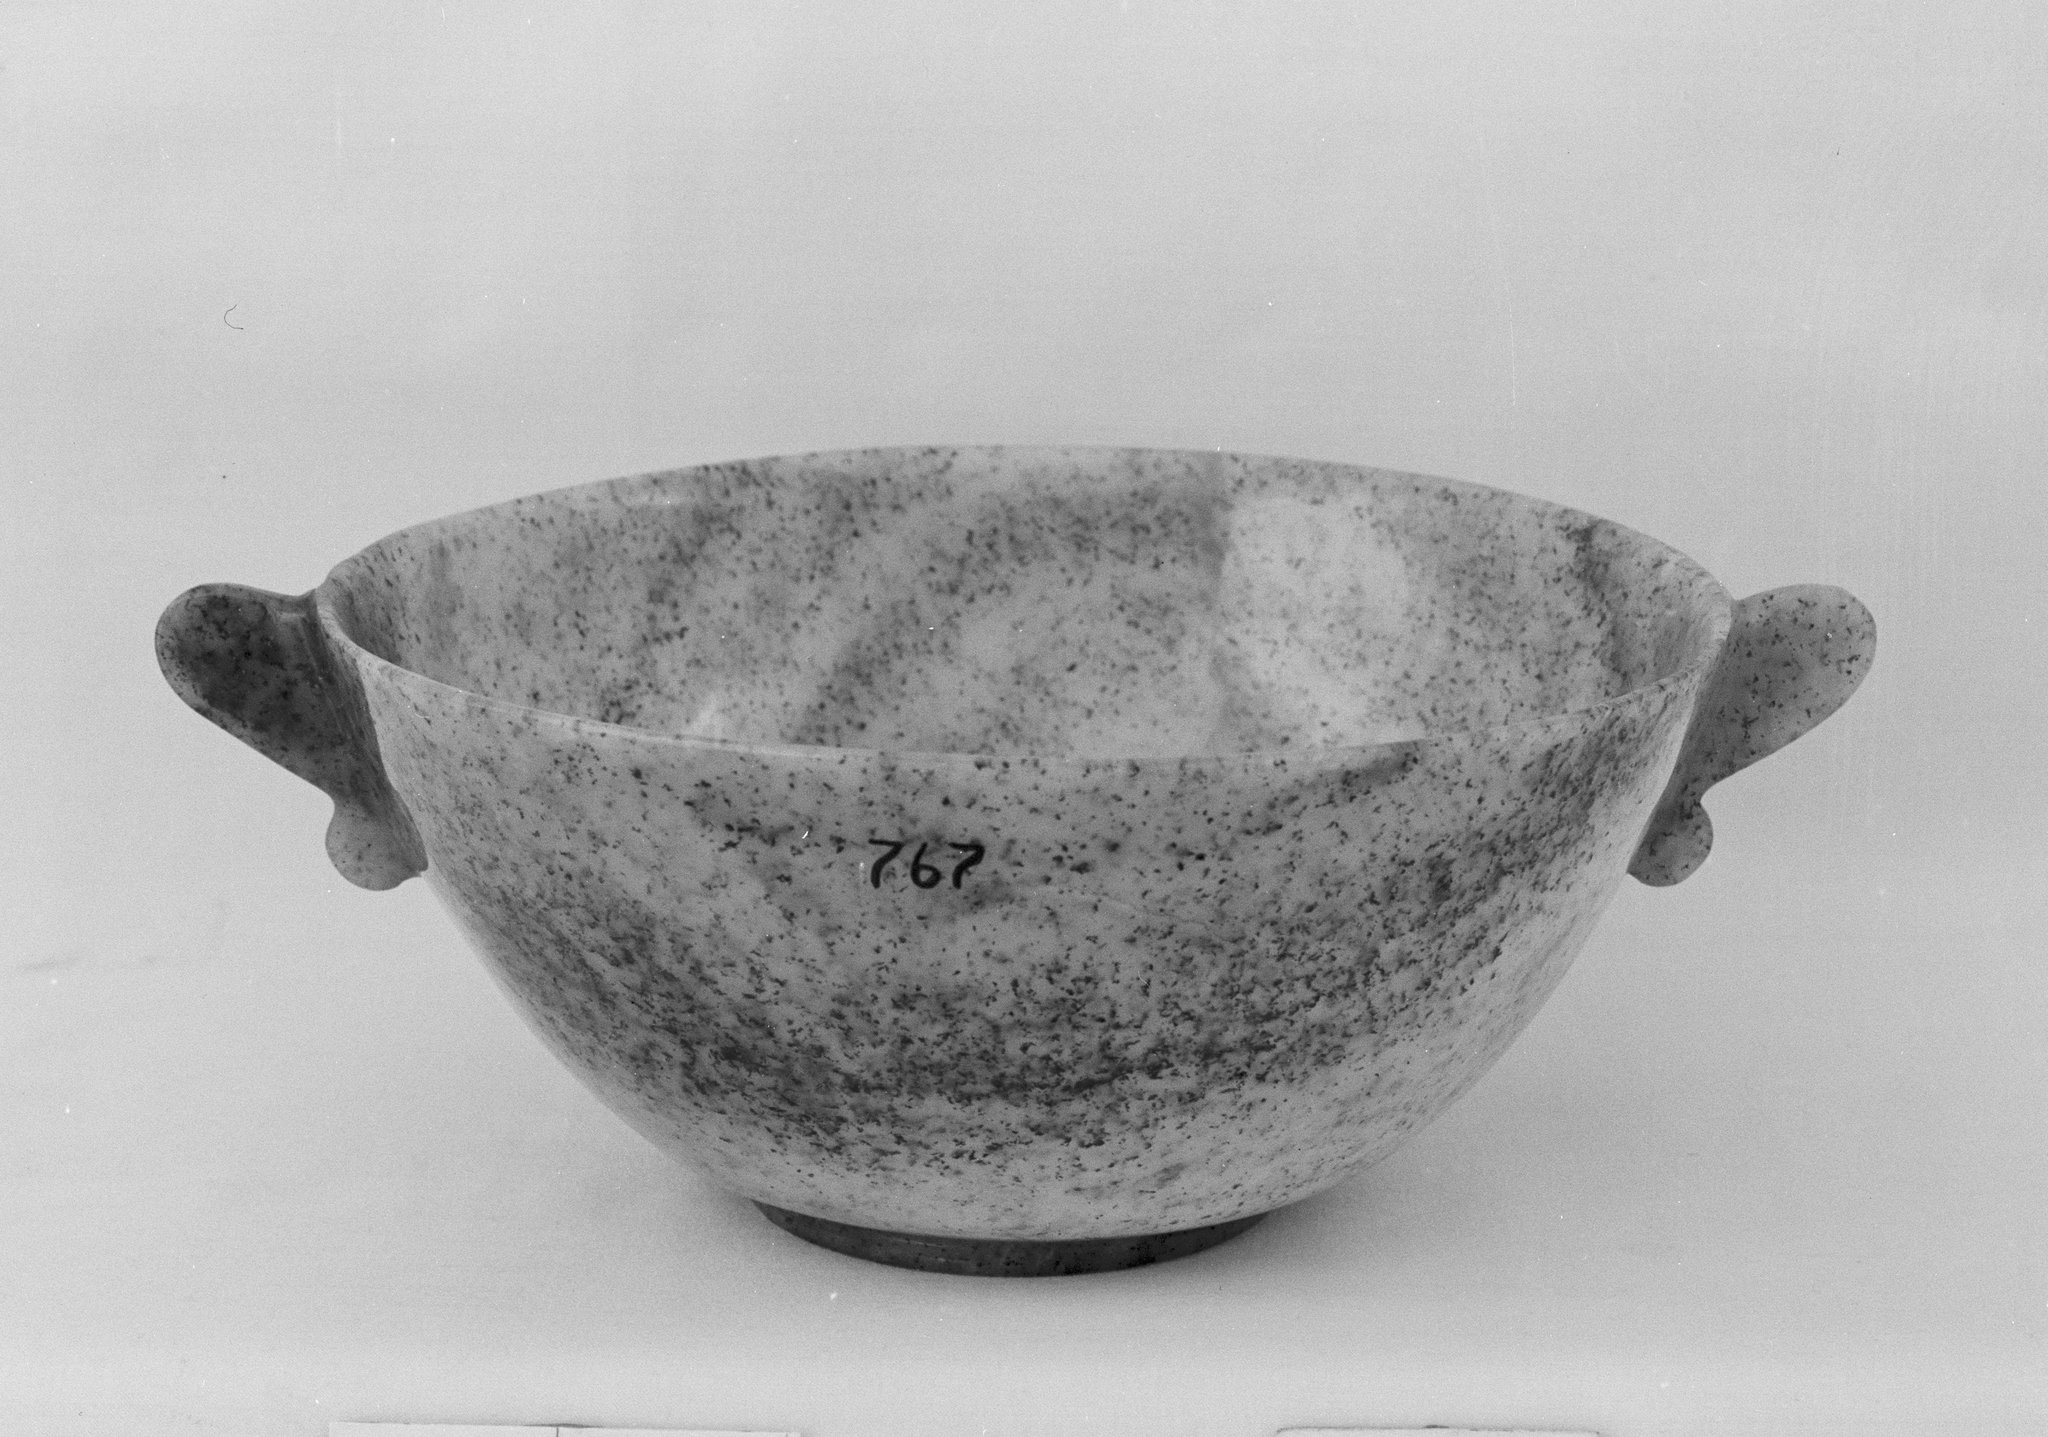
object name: bowl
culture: indian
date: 1701-1800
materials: jade